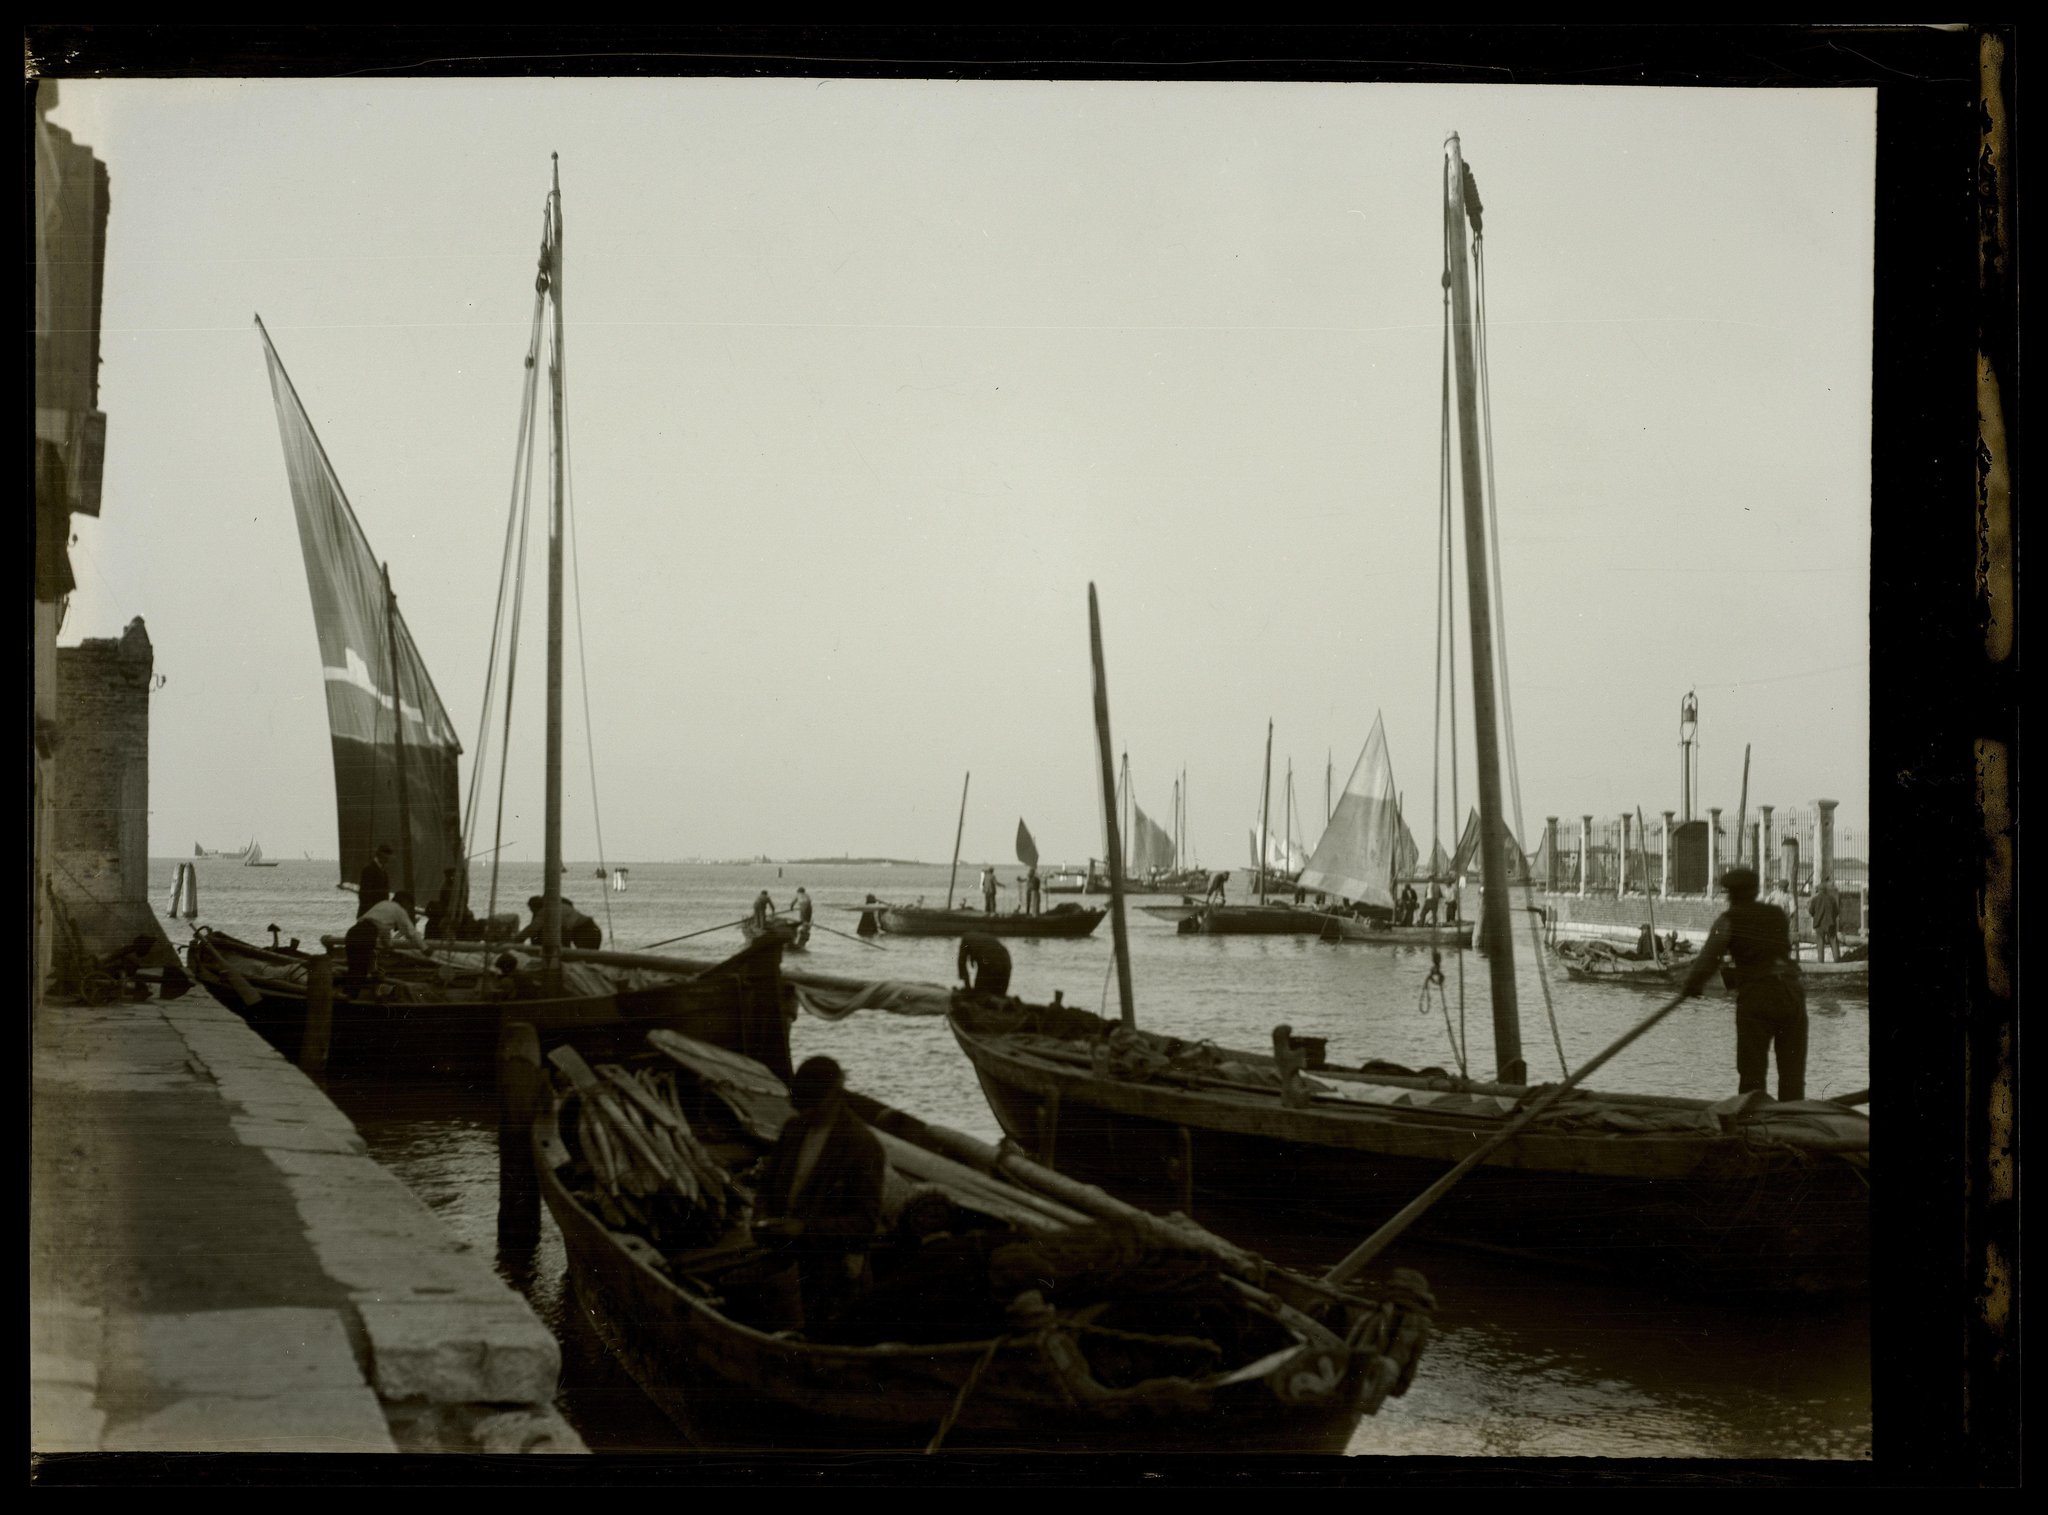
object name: negative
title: Filmnegatief met opname van Venetië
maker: Anonymous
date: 1907-1935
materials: film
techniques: gelatin silver negative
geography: venice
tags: venice